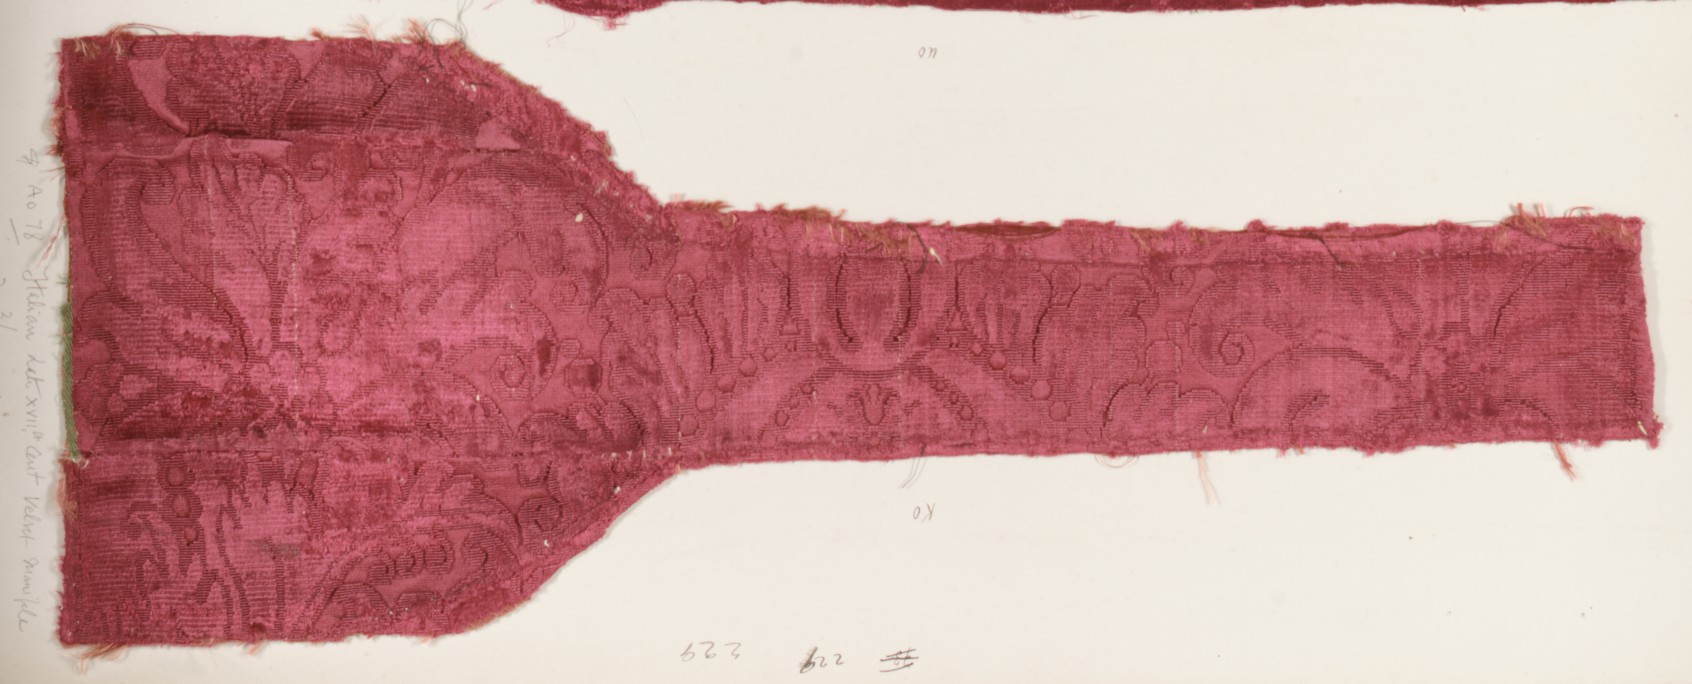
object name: fragment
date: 1667-1700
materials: silk